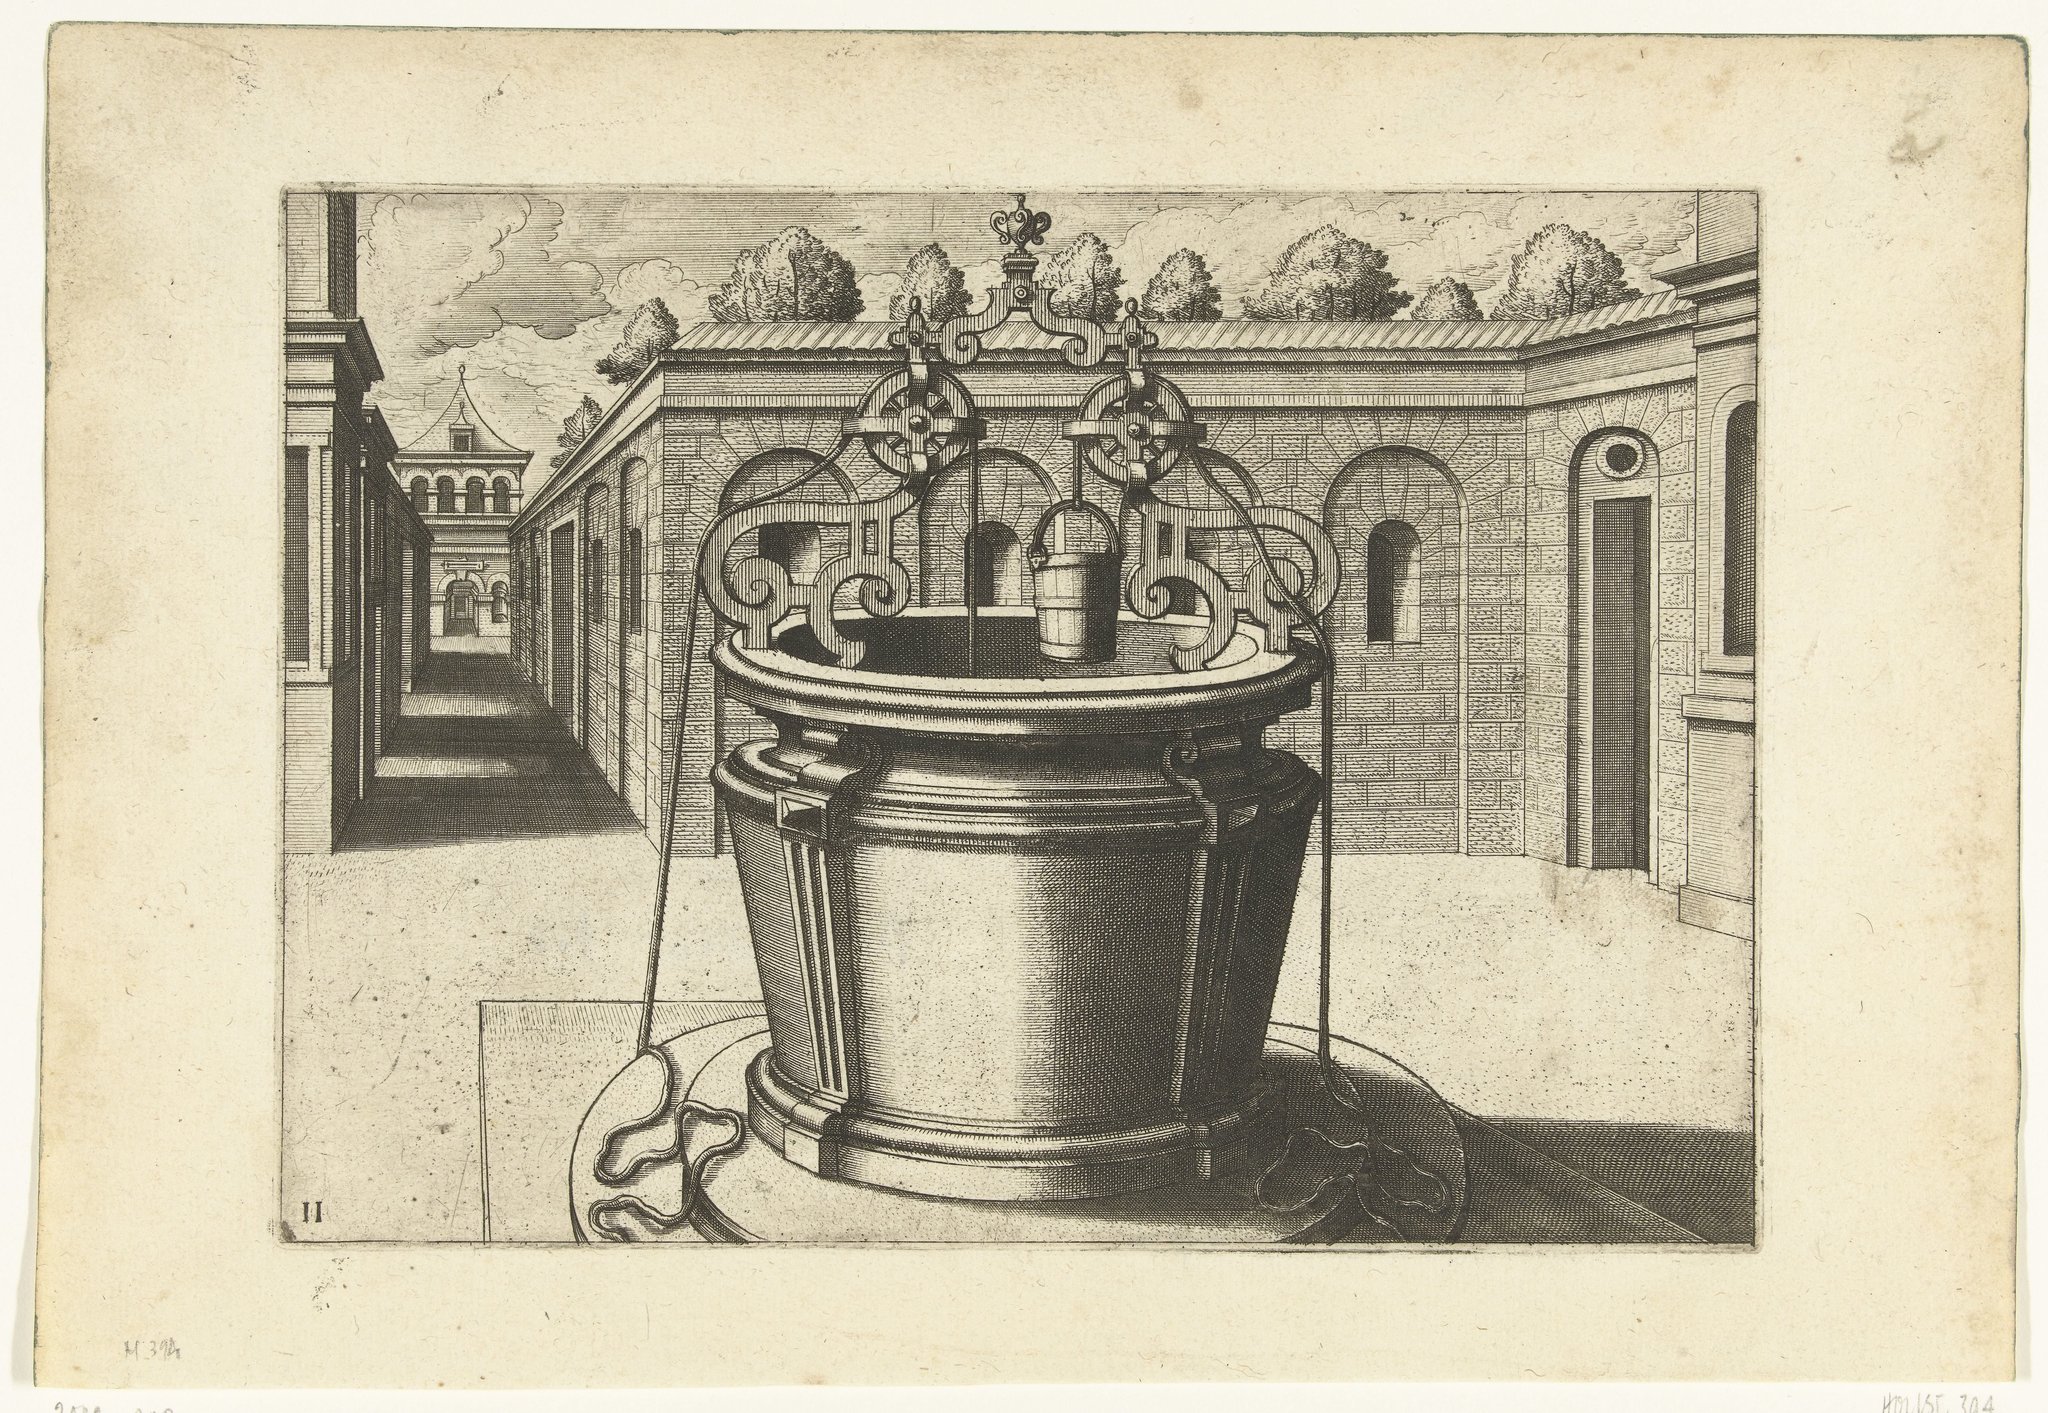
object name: print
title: Waterputten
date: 1574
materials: paper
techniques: etching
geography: antwerp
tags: well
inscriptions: number: ‘11’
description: Plein voor een ommuurde tuin met een ronde waterput. Op de rand zijn twee constructies van rolwerk bevestigd waaraan twee akers over katrollen hangen. No. 11 uit serie van 24 kleine waterputten